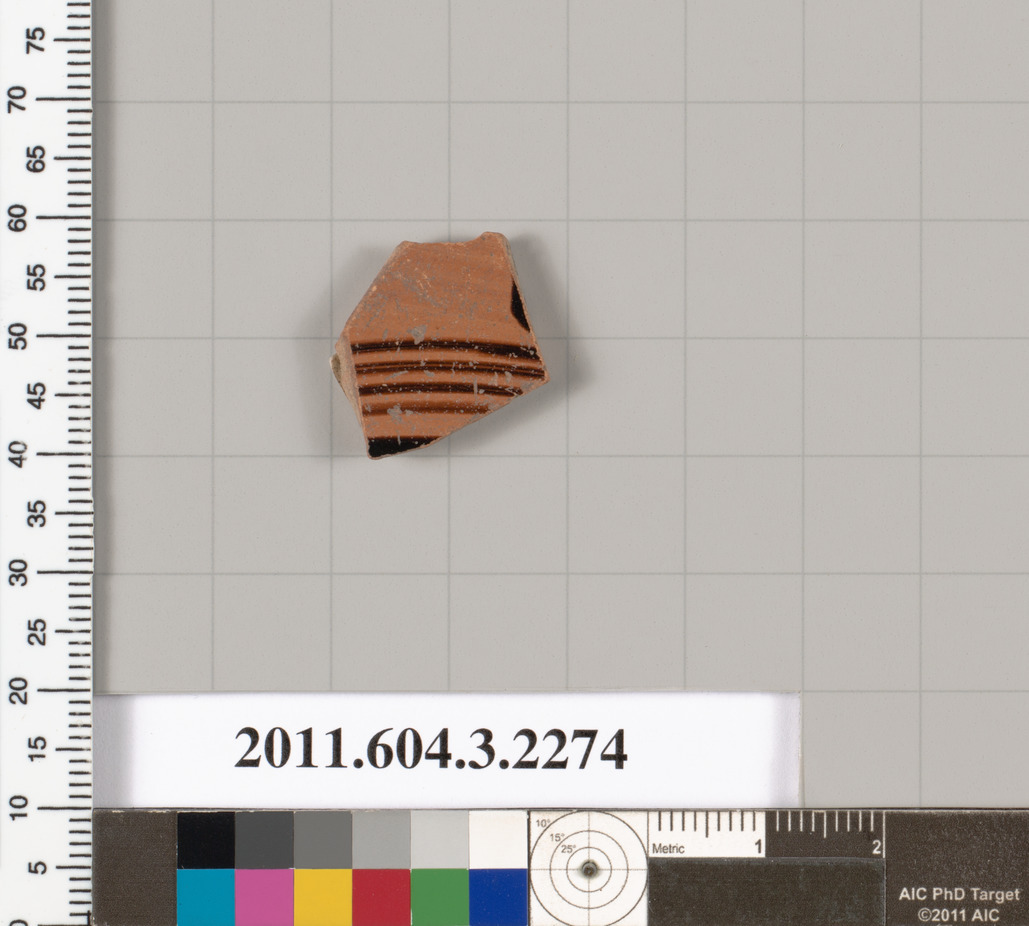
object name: kylix fragment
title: Terracotta fragment of a kylix (drinking cup)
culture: greek, attic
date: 600-401 BCE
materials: terracotta